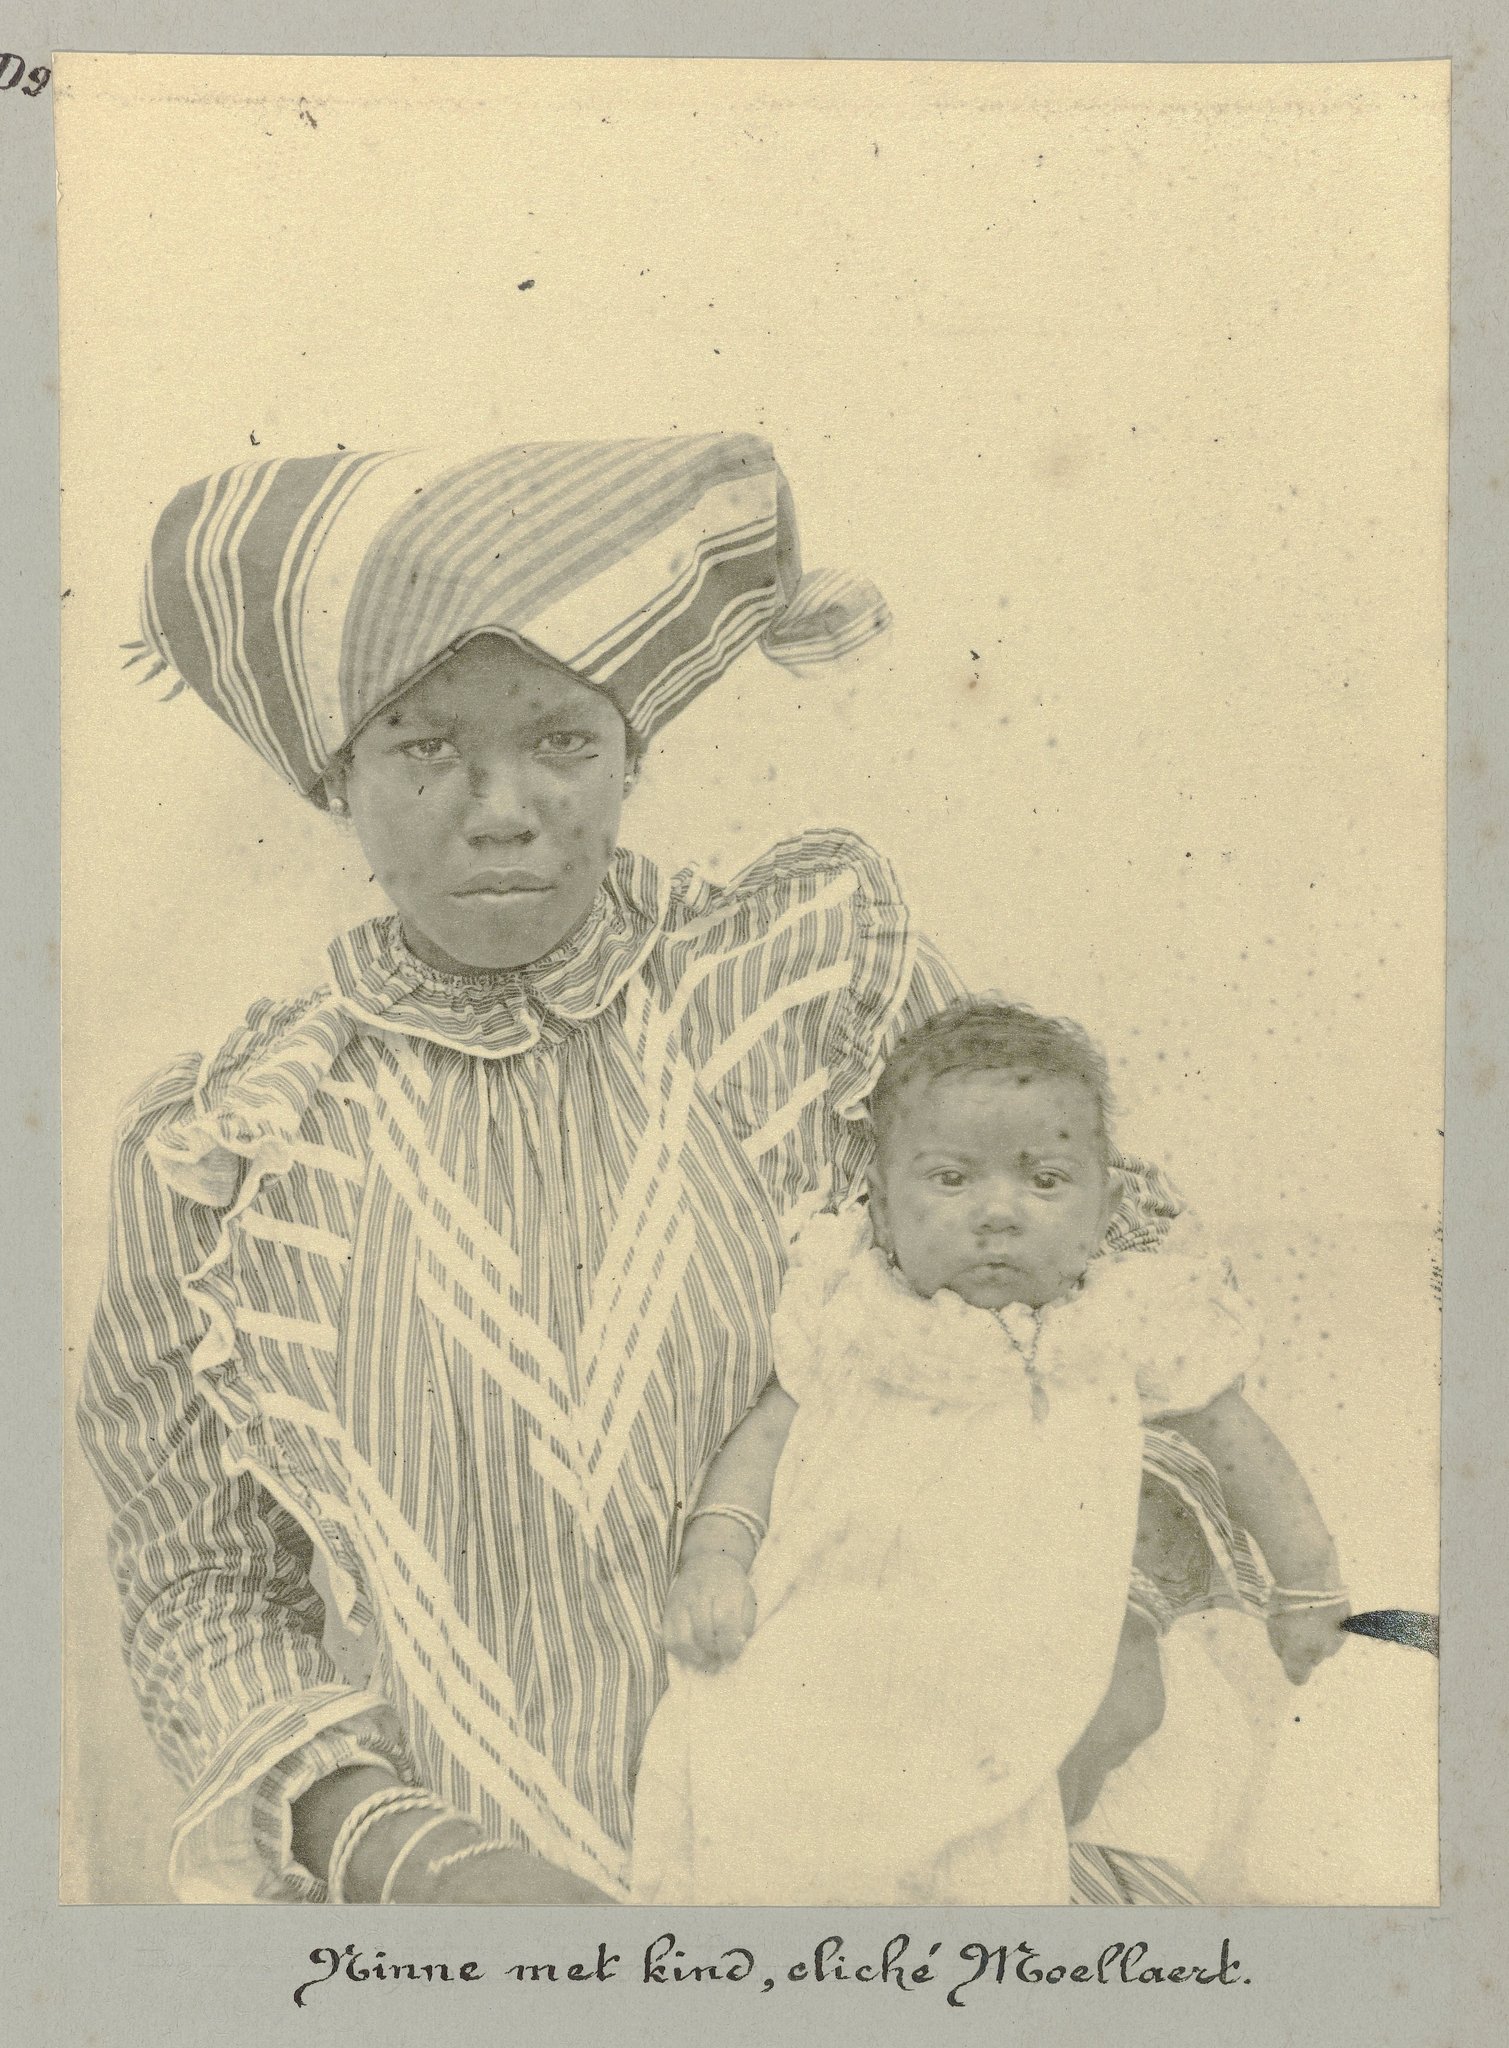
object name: photograph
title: Ninne met kind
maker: moellaert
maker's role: fotograaf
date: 1906-1913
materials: photographic support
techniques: gelatin silver print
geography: suriname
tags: suriname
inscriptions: inscription: ‘D9 / Ninne met kind, cliché Moellaert.’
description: Portret van een vrouw met kind, de vrouw wordt in het onderschrift aangeduid als Ninne. Onderdeel van het fotoalbum Souvenir de Voyage (deel 3), over het leven van de familie Dooyer in en rond de plantage Ma Retraite in Suriname in de jaren 1906-1913.